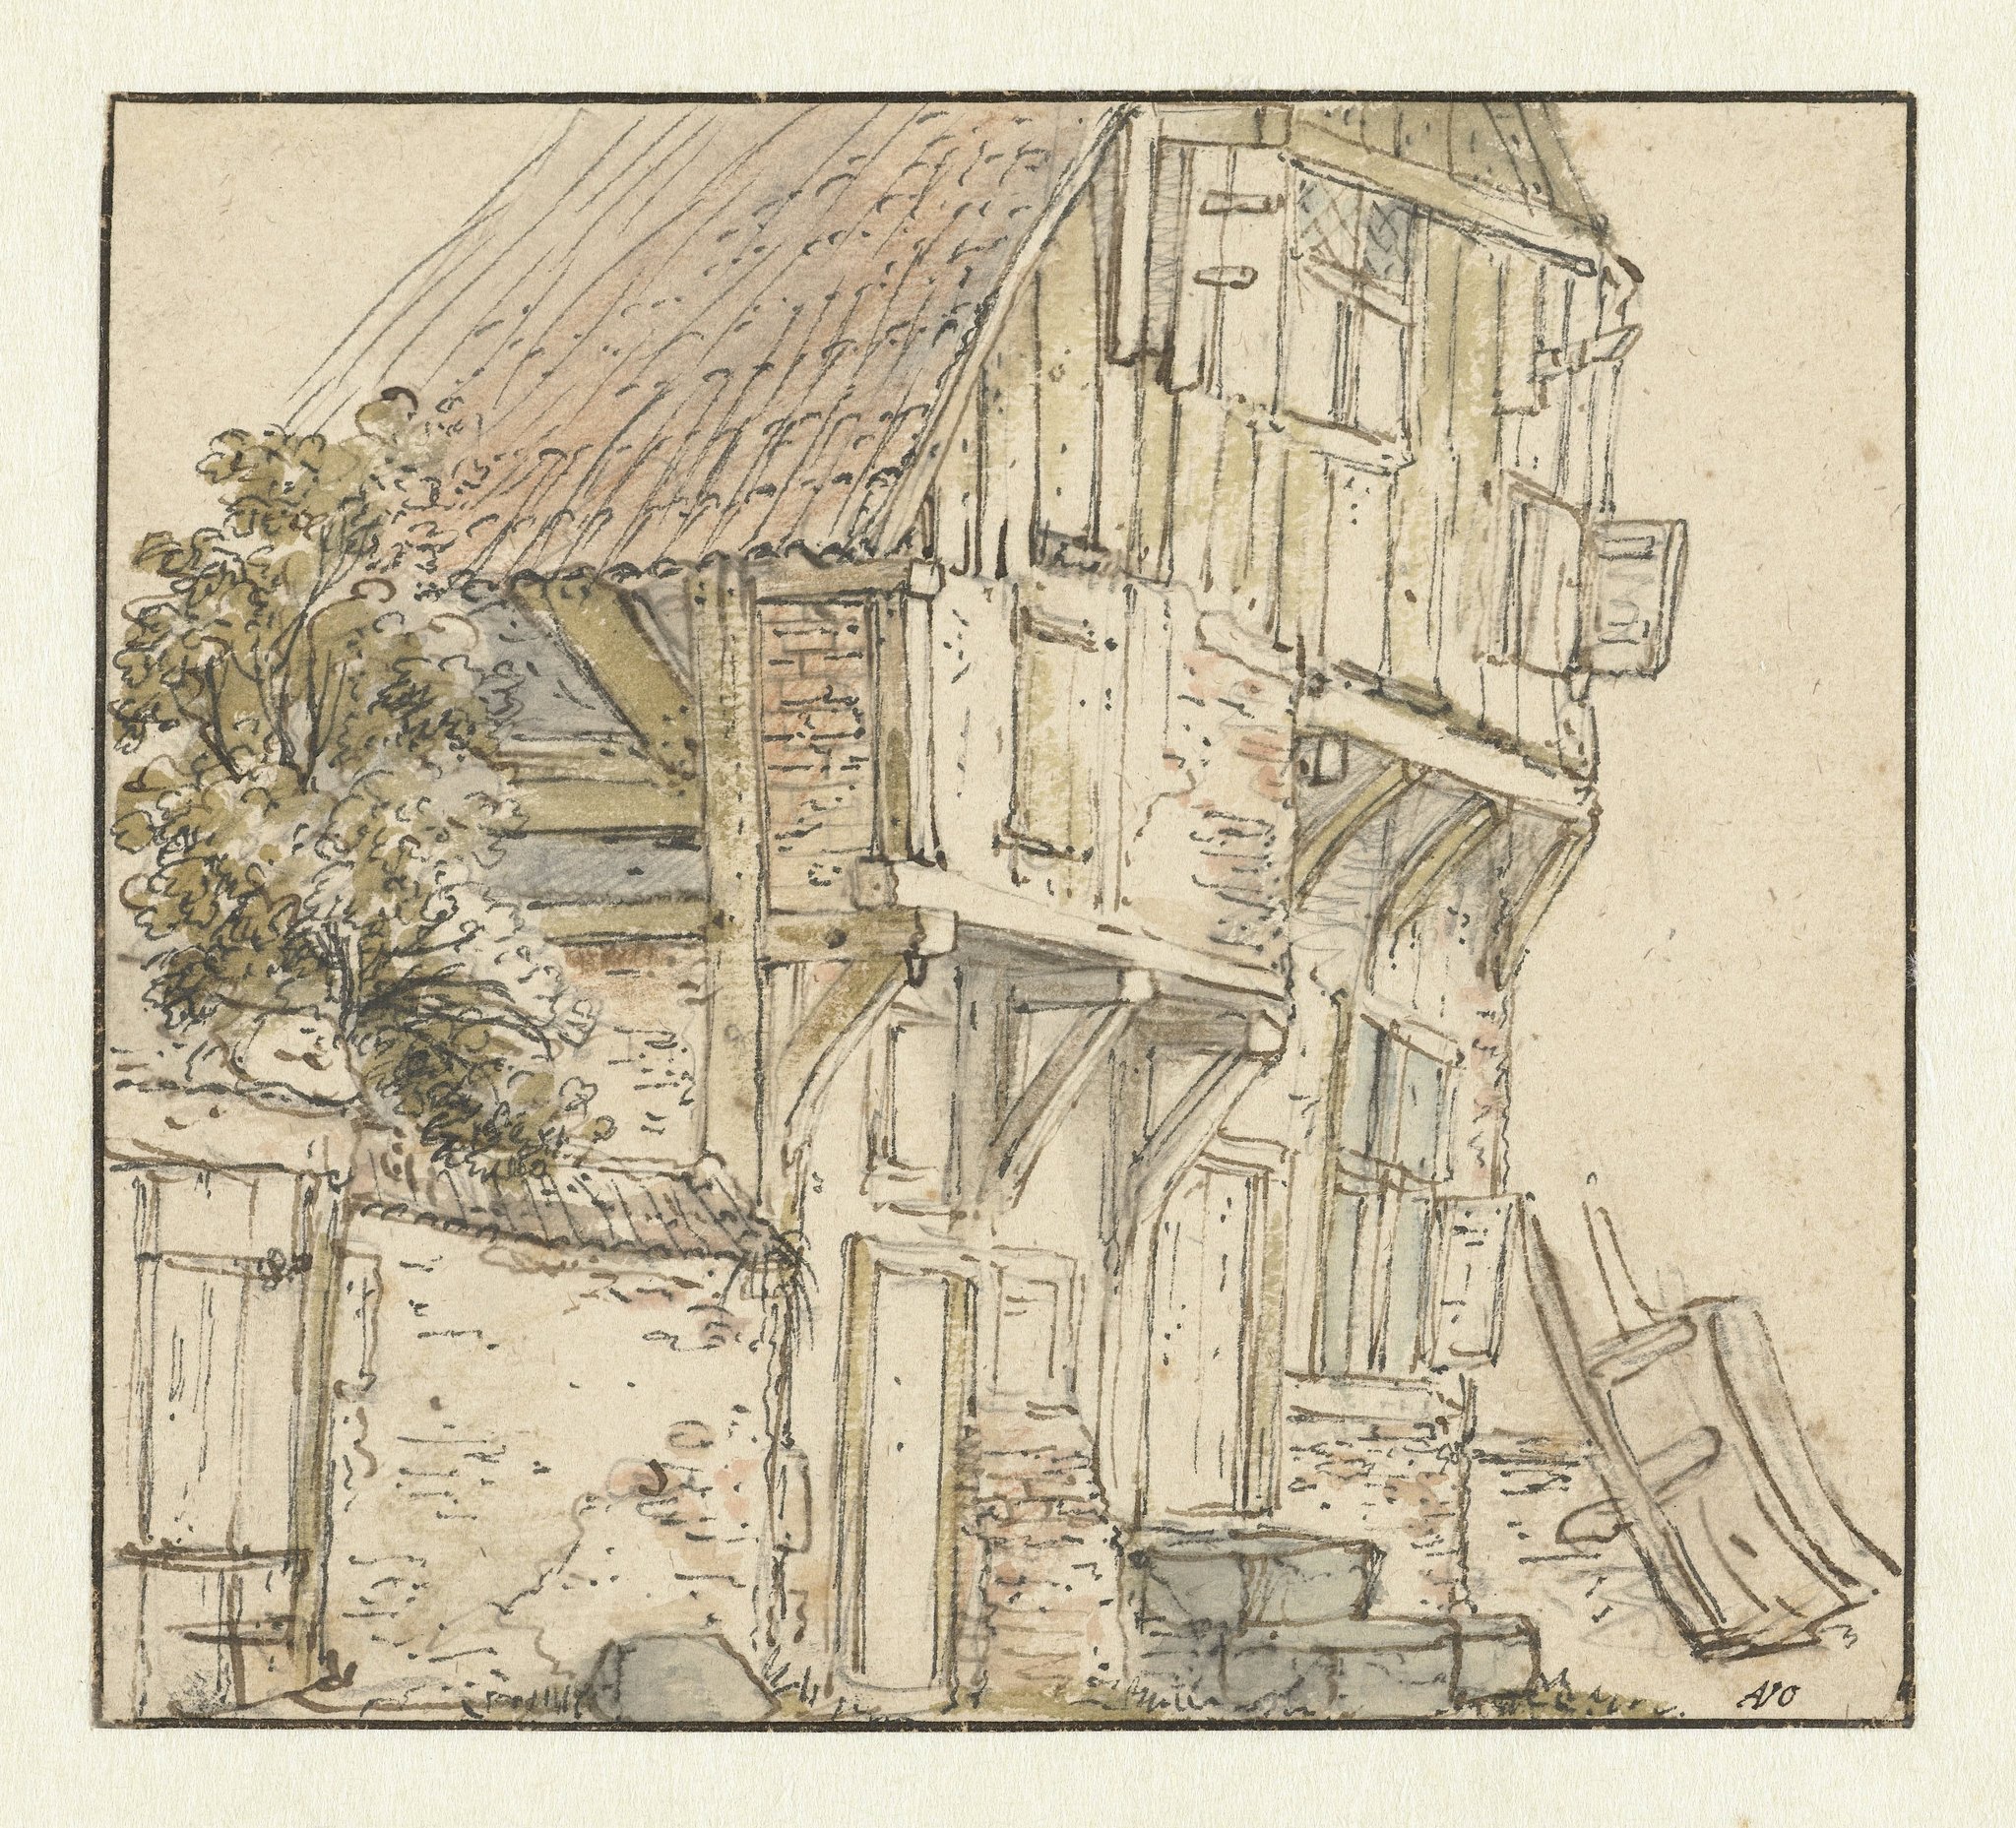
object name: drawing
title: Boerenhuis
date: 1631-1649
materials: chalk, ink, paper, pencil, watercolor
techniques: brush, pen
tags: façade (of house or building)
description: Boerenhuis met links een tuinmuur en rechts een wagen.